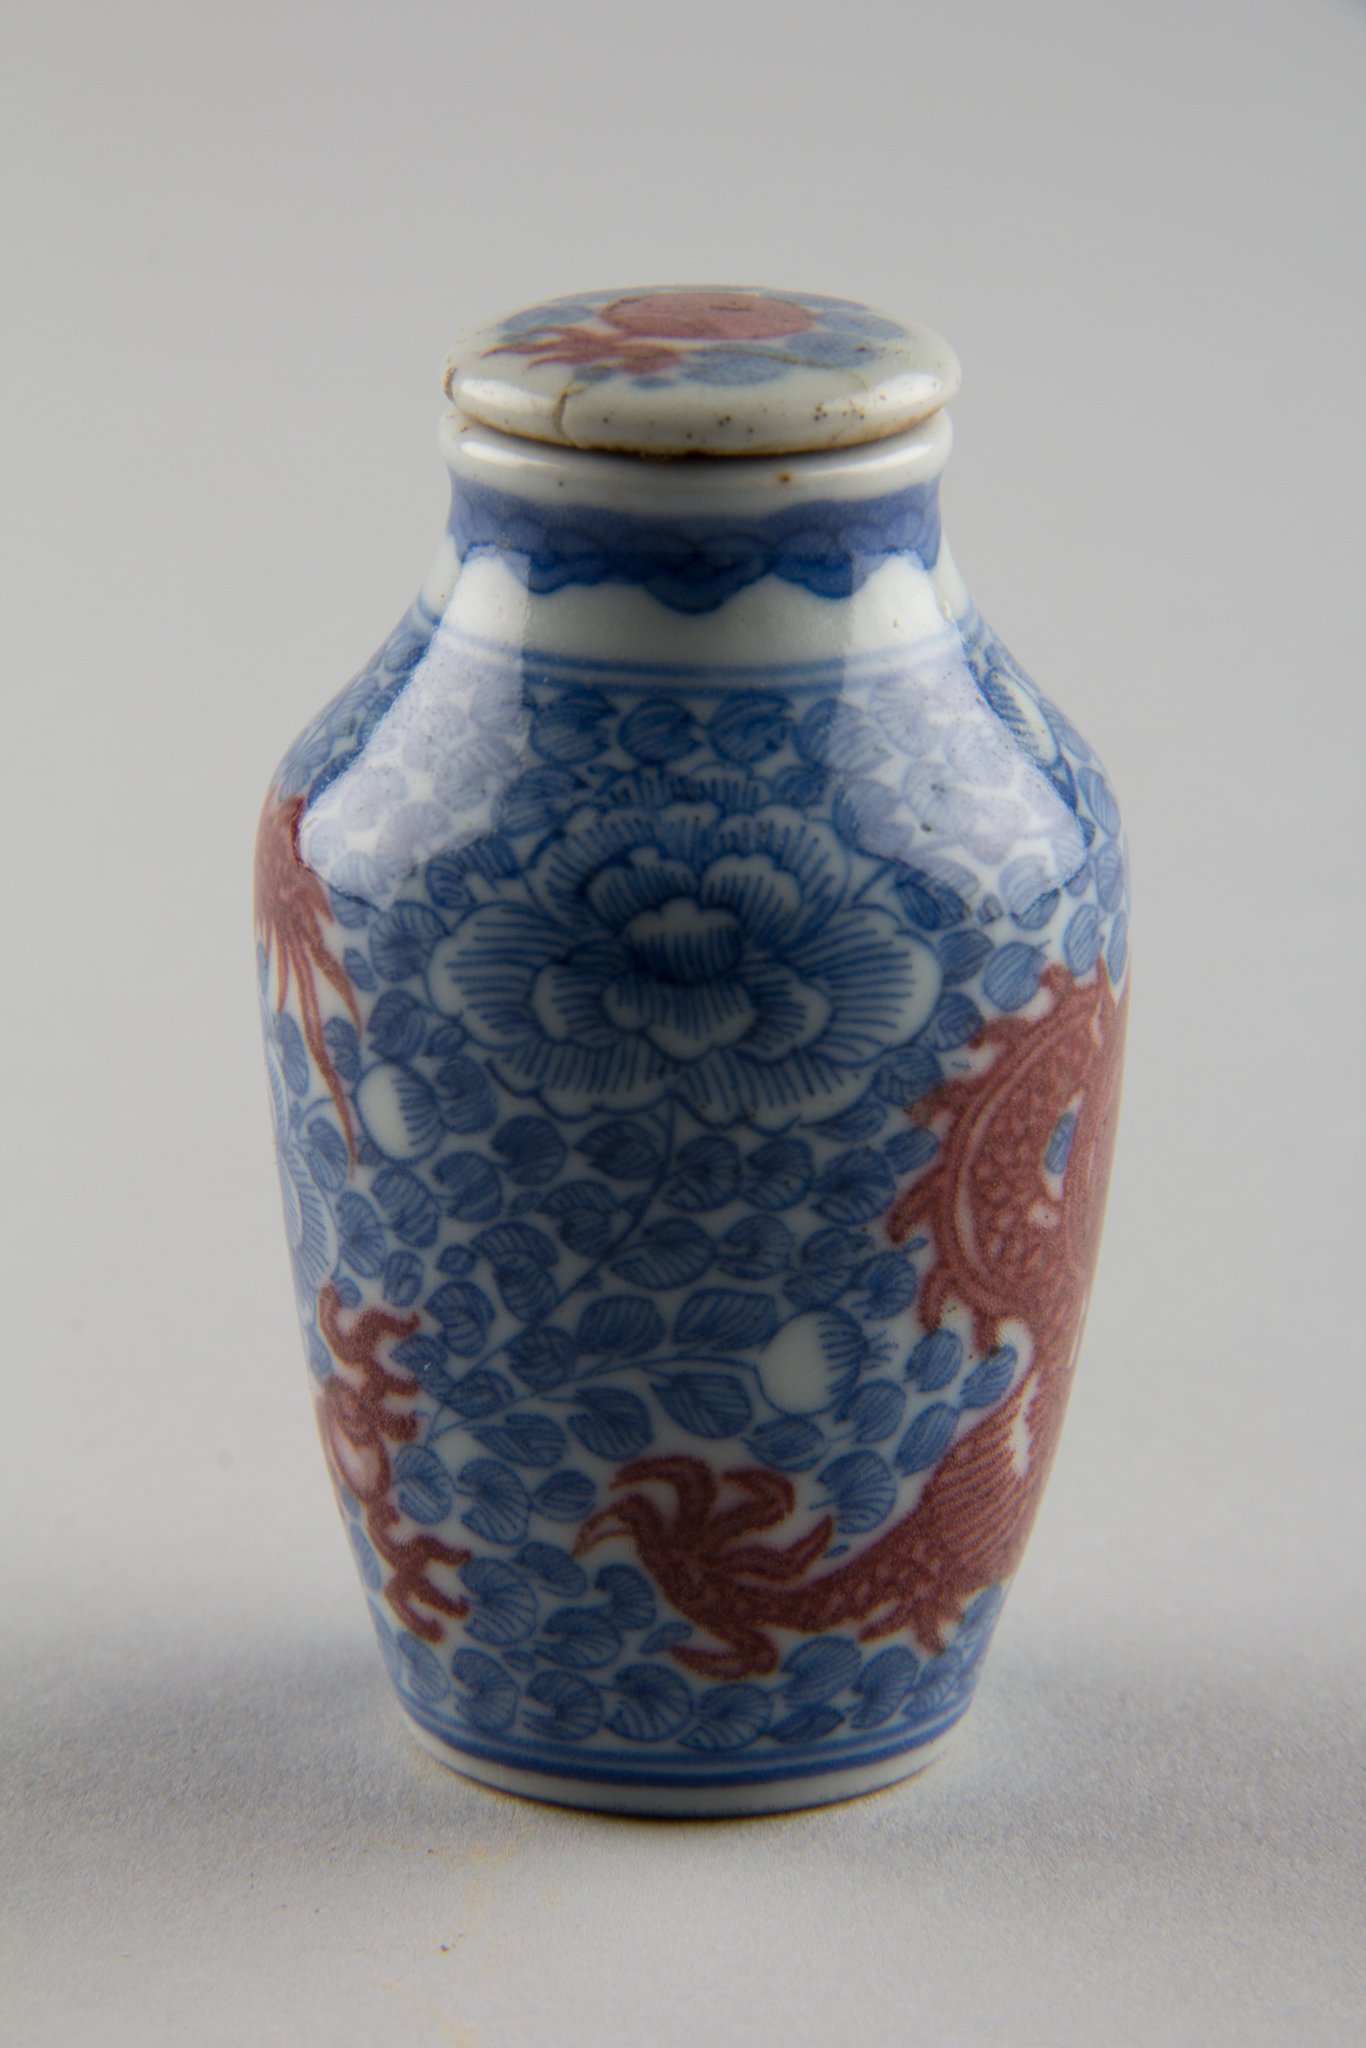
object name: snuff bottle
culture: chinese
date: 1640-1911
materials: porcelain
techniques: painting, underglaze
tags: dragons